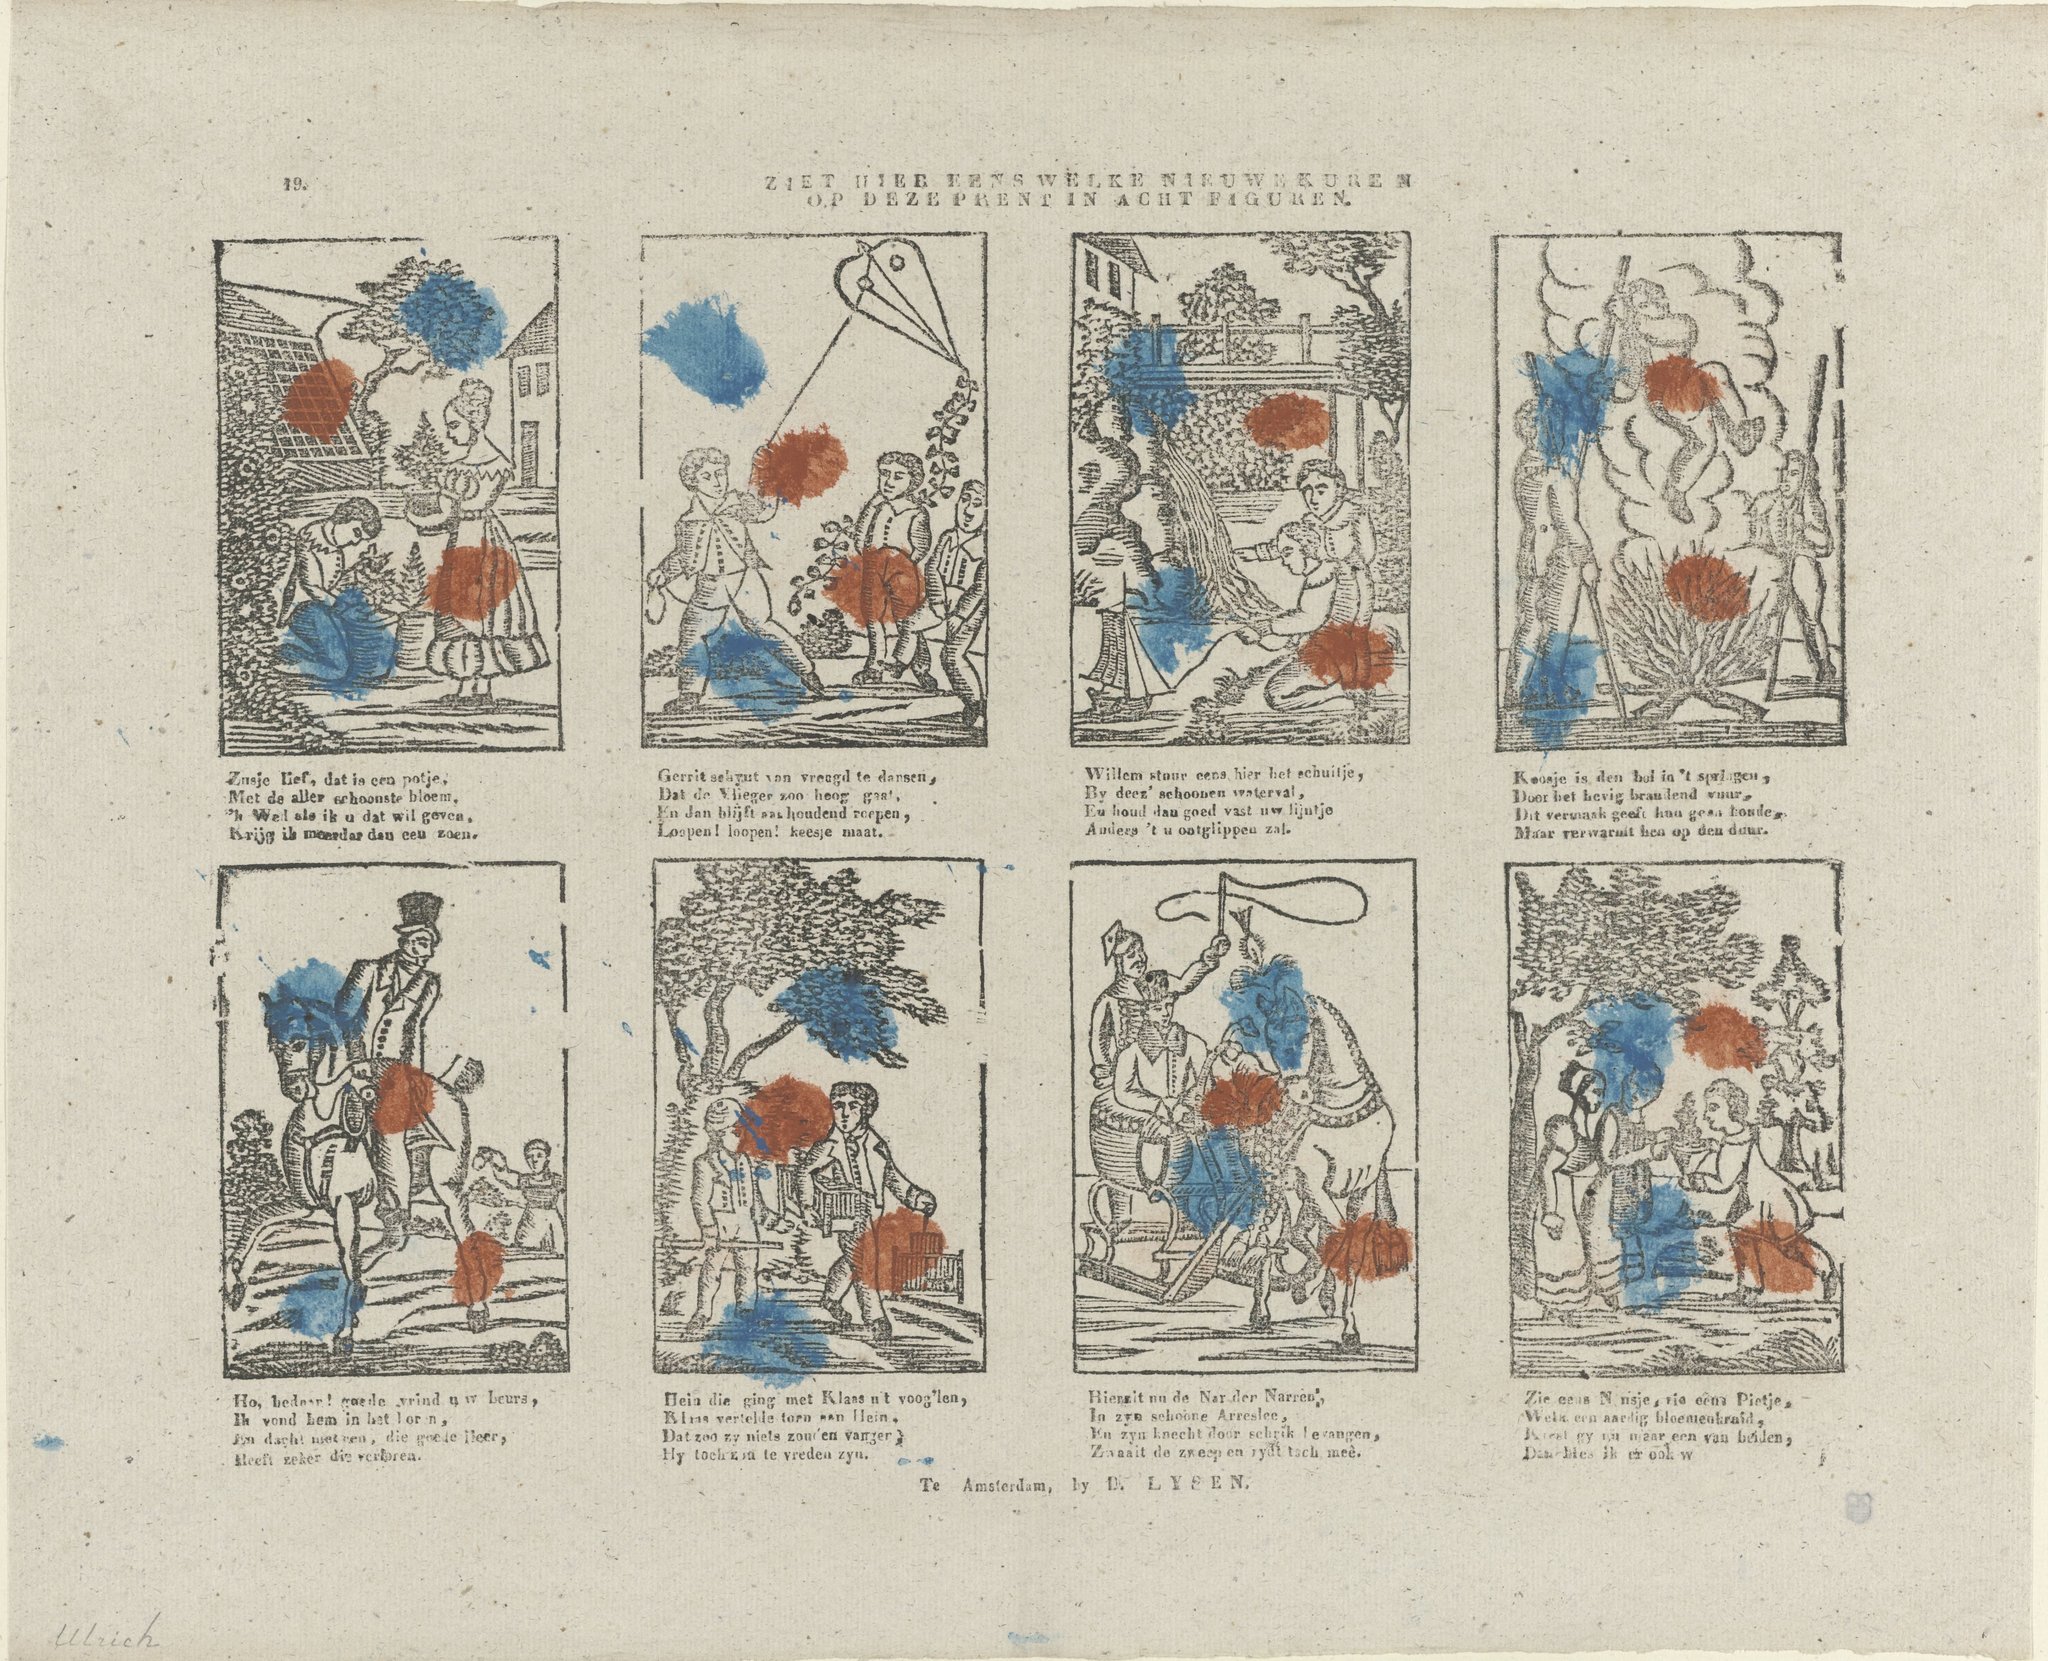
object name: print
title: Ziet hier eens welke nieuwe kuren / Op deze prent in acht figuren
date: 1836-1849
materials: paper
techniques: colour, letterpress printing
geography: netherlands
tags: children's games and plays, child playing with animals, (flying a) kite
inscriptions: collector's mark: Lugt 2760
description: Blad met 8 voorstellingen van kinderspelen, waaronder vliegeren, schuitje varen en vogels vangen. Onder elke voorstelling een vierregelig. Genummerd linksboven: 19.